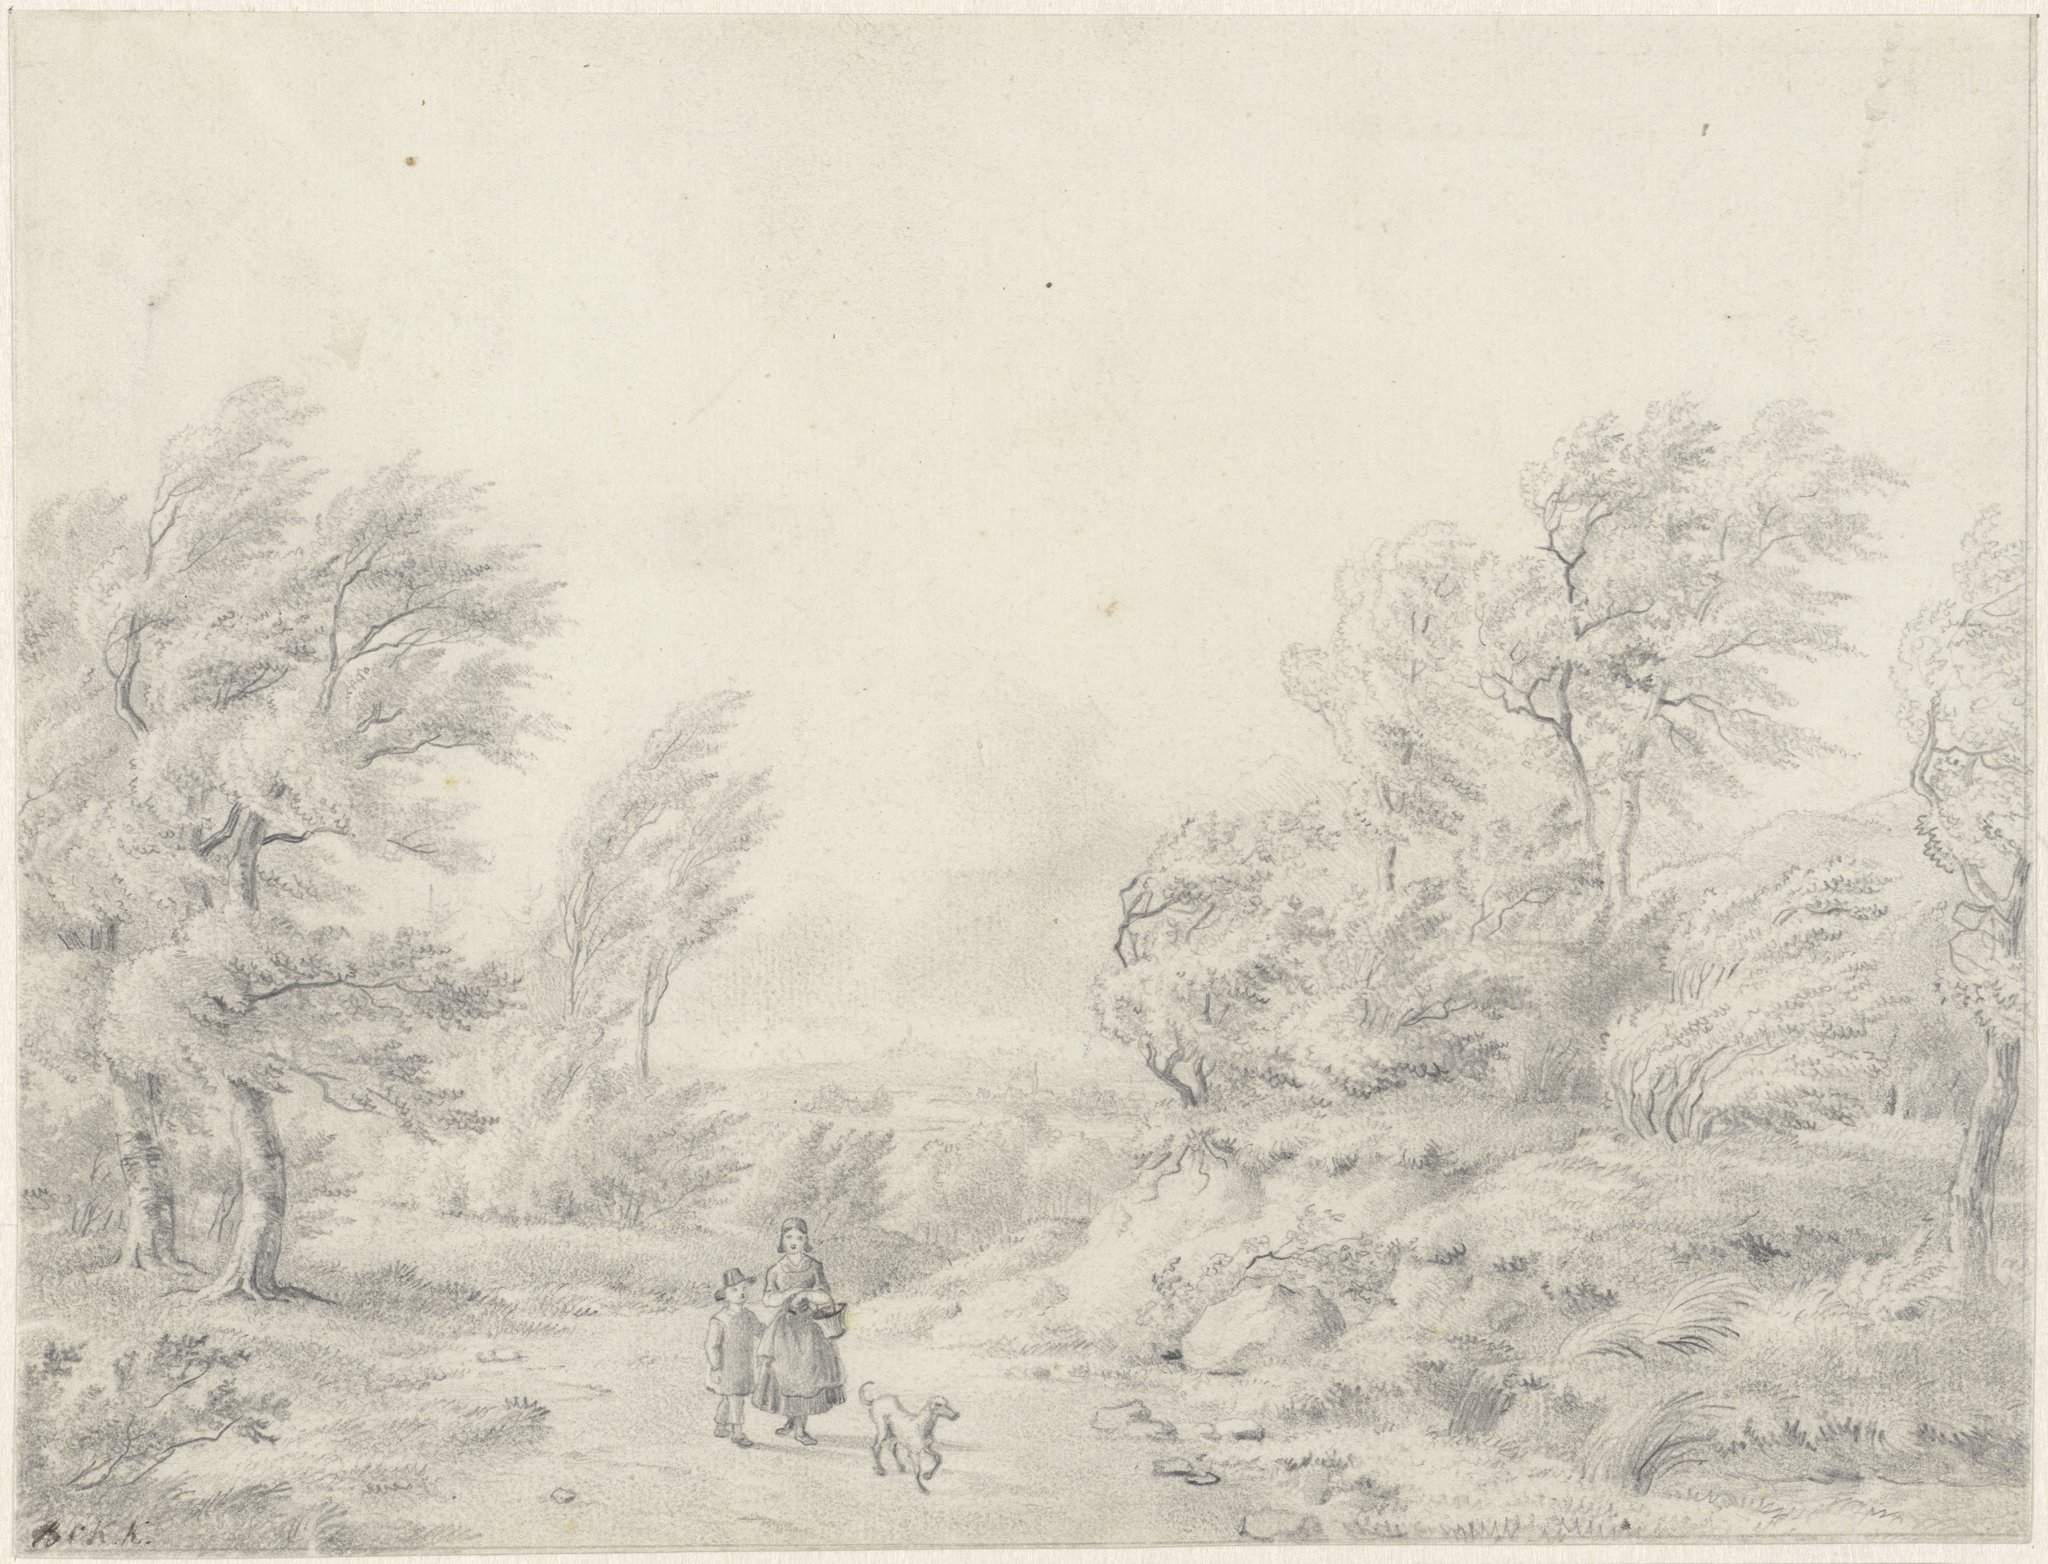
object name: drawing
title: Bij Arnhem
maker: barend cornelis koekkoek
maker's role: draughtsman, painter, print maker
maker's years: 1803-1862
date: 1813-1862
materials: chalk, paper, pencil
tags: landscapes in the temperate zone, arnhem